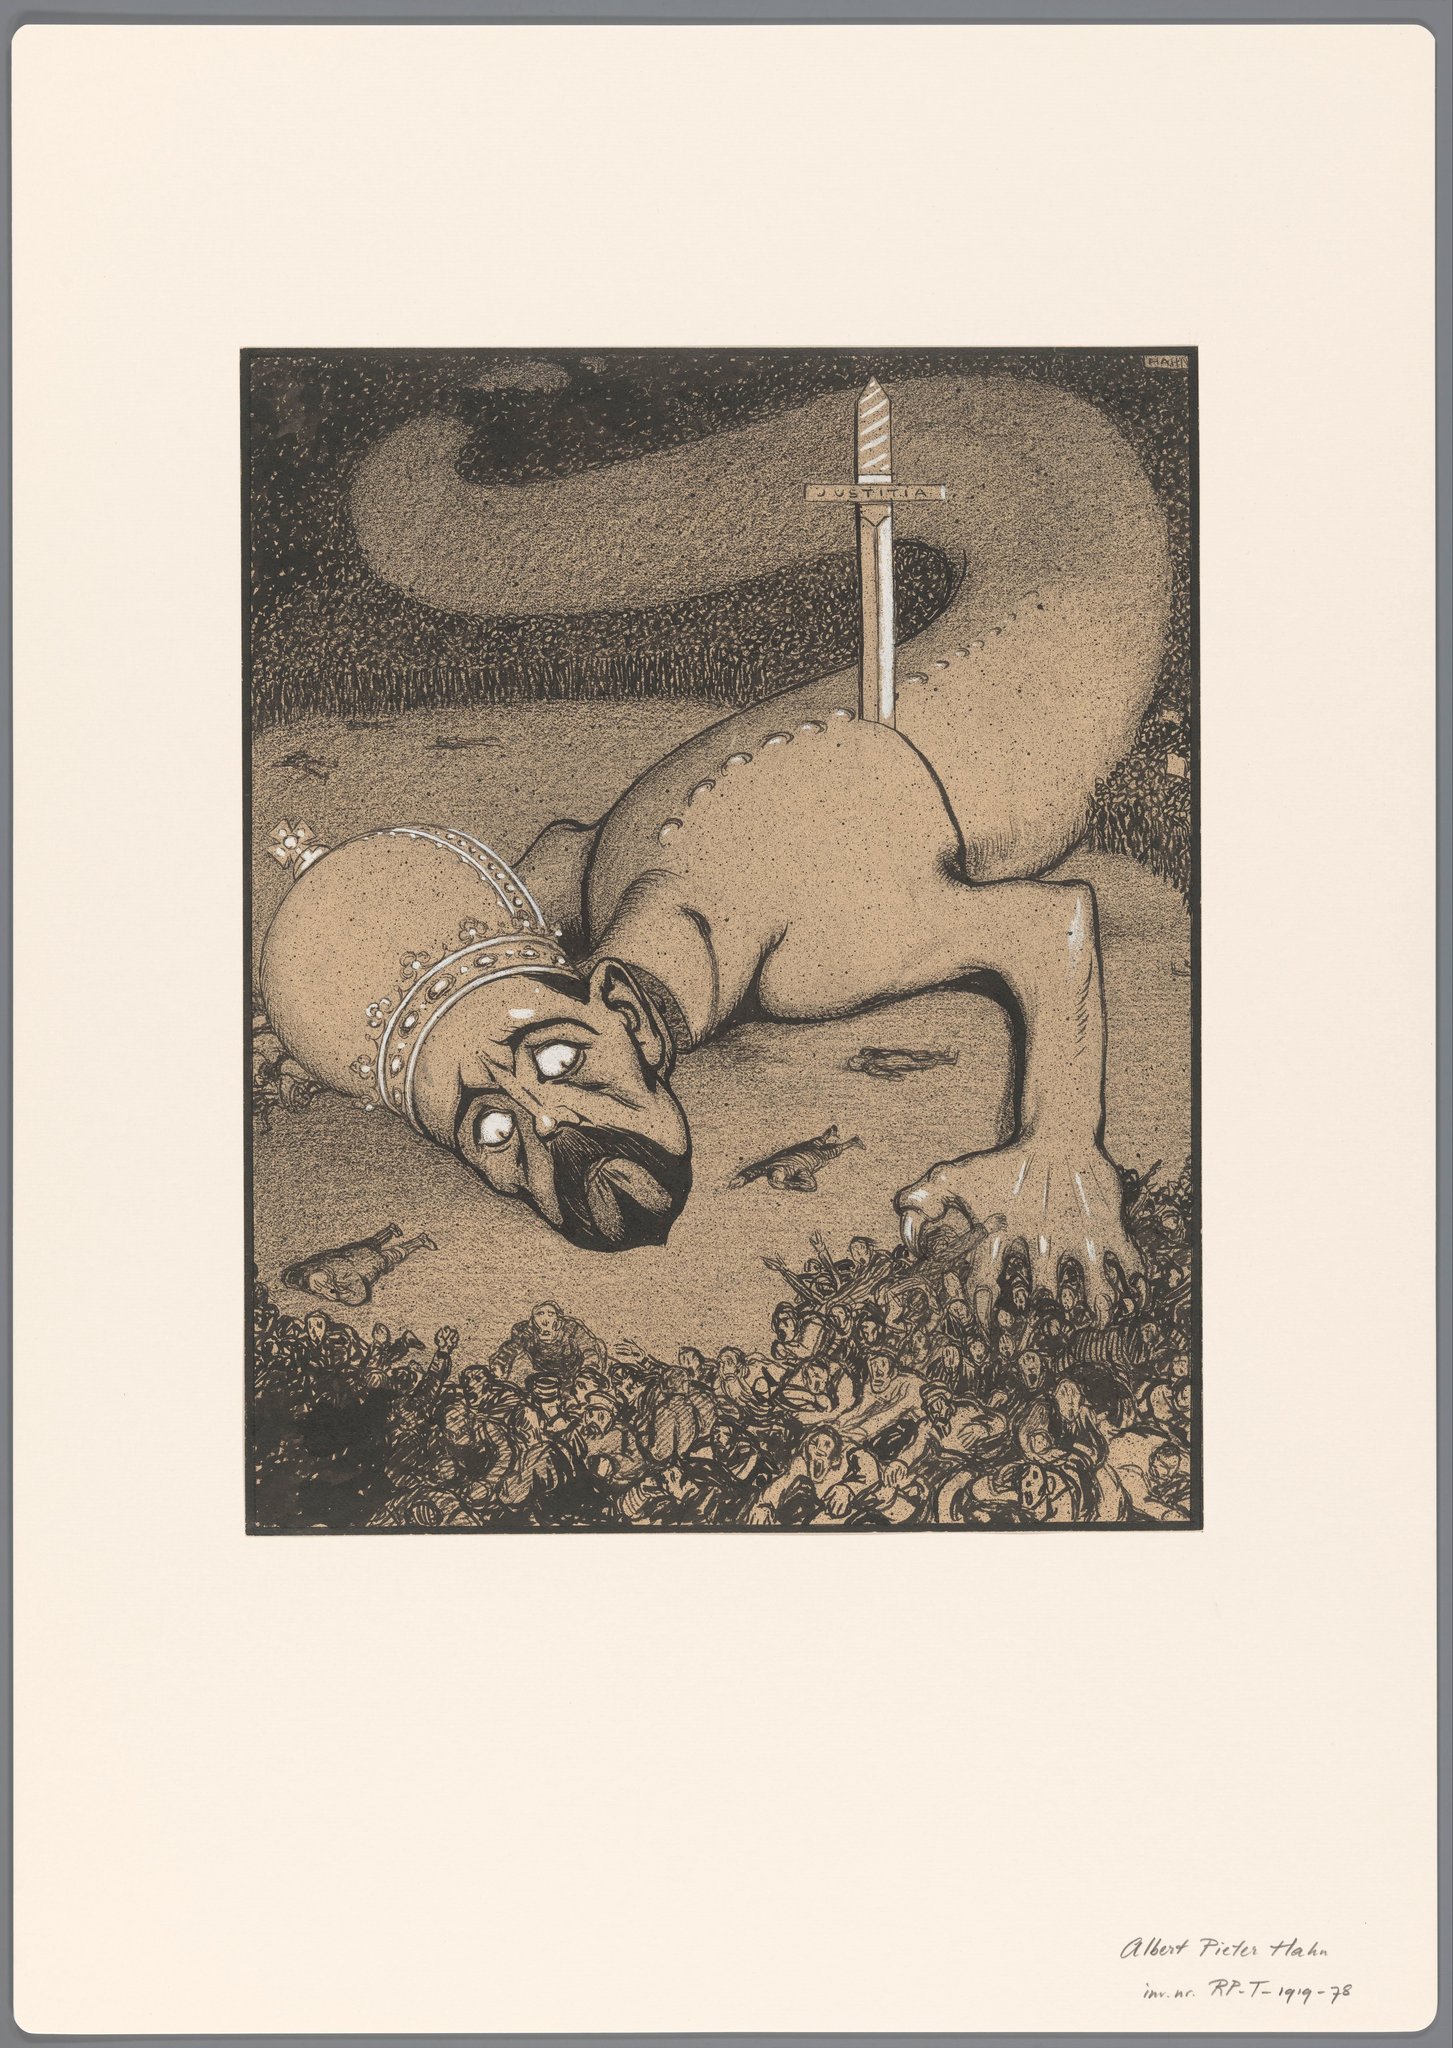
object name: design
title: Ontwerp voor een politieke spotprent: slang met gekroond hoofd neergestoken door zwaard van Justitia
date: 1887-1919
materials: chalk, paint, ink, paper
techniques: brush, pen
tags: political caricatures and satires